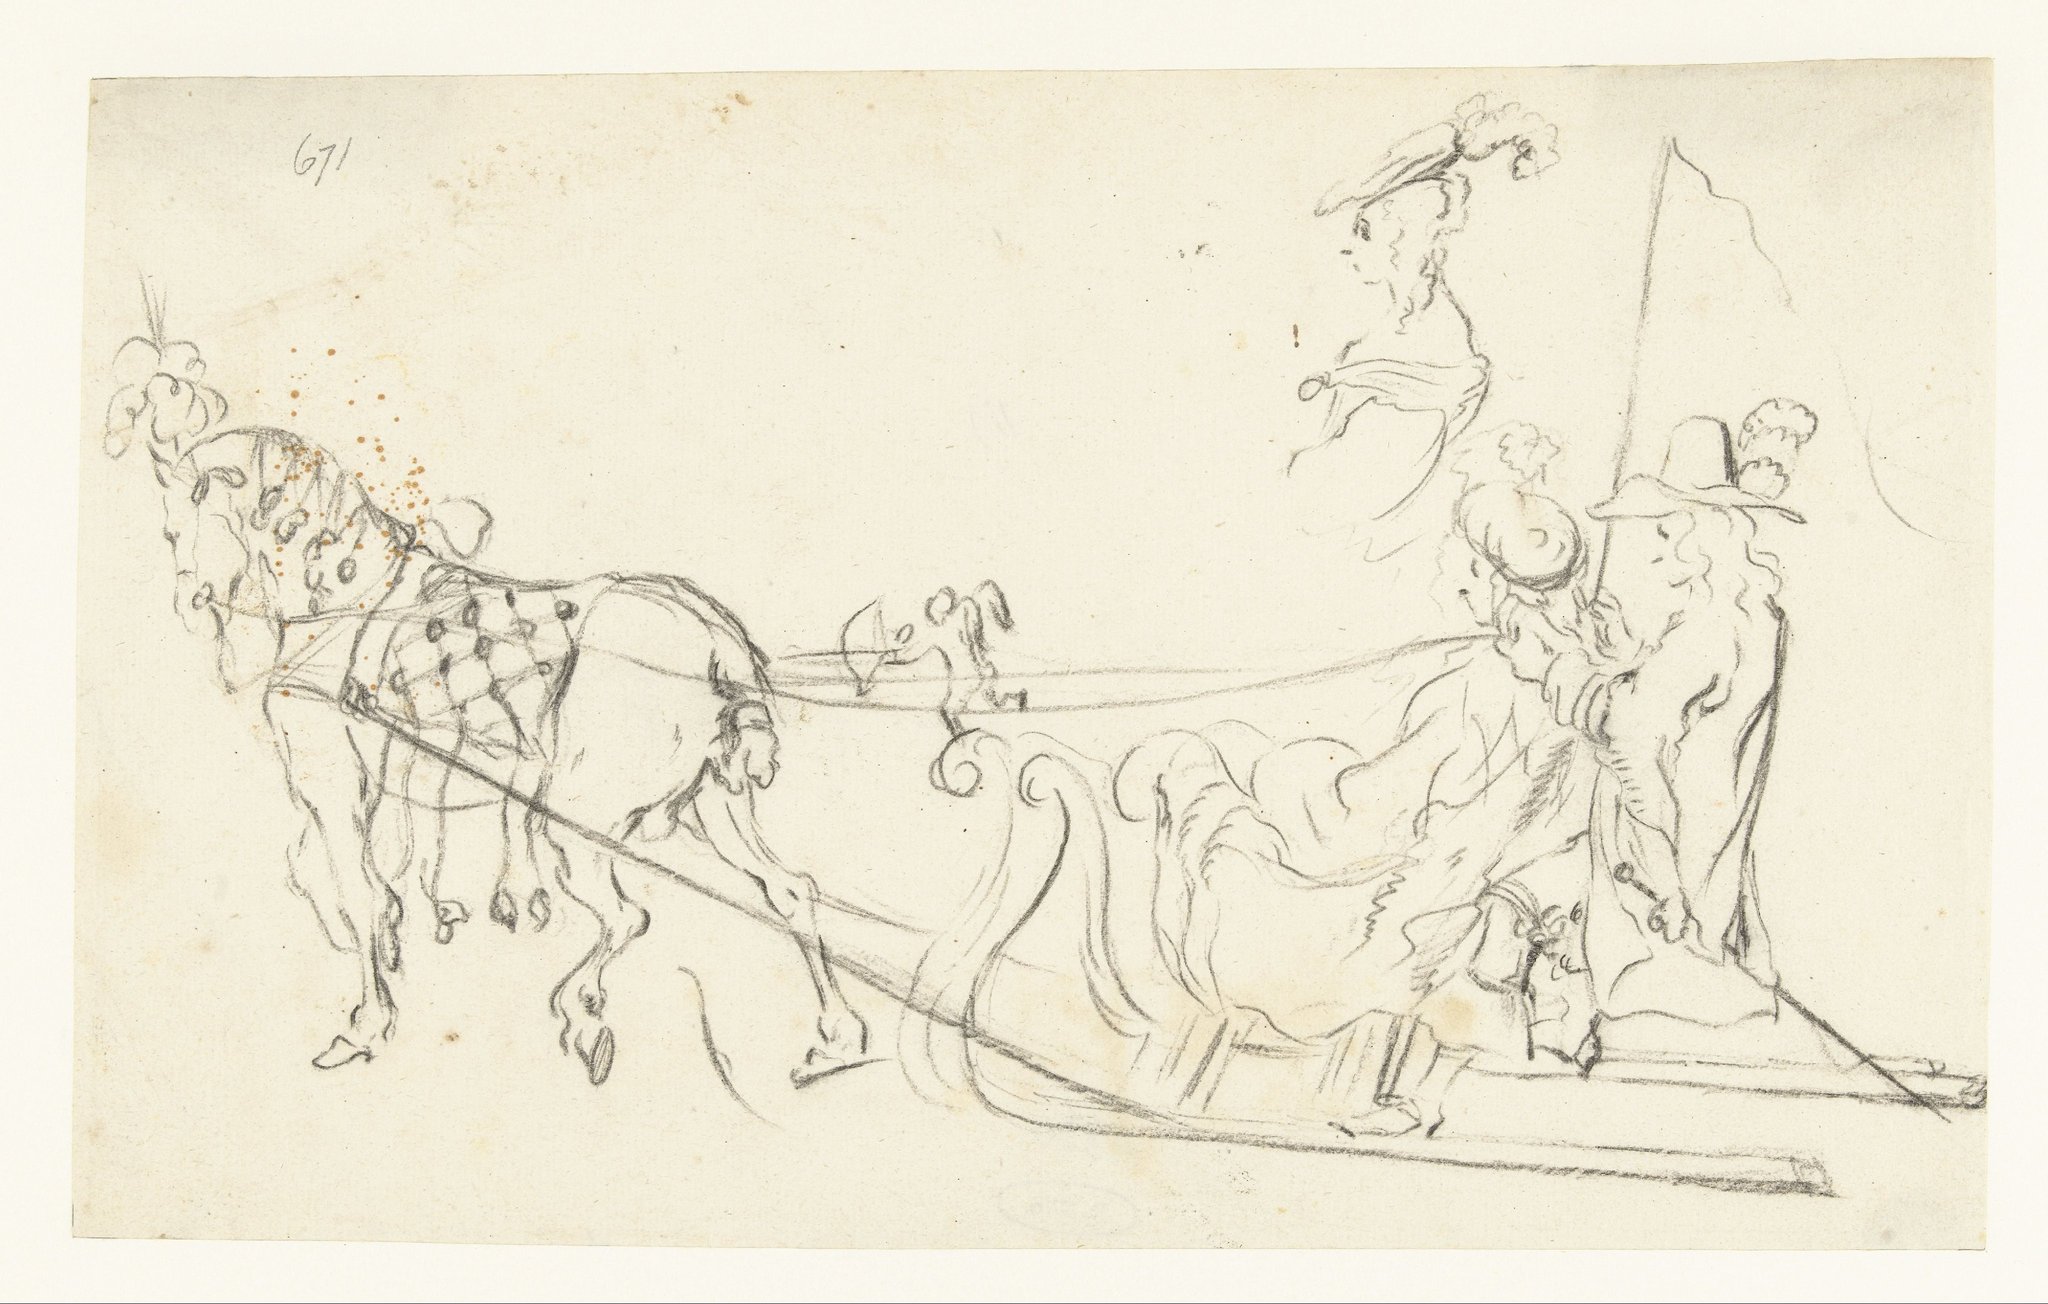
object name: drawing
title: Paar in een door een paard getrokken arrenslee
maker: gesina ter borch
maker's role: draughtsman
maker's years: 1633-1690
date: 1656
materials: chalk, paper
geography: deventer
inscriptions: annotation: ‘Copie nr G. ter B.Jr A 839’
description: 1 van 2 kopieën naar Gerard (II), GJr 82.